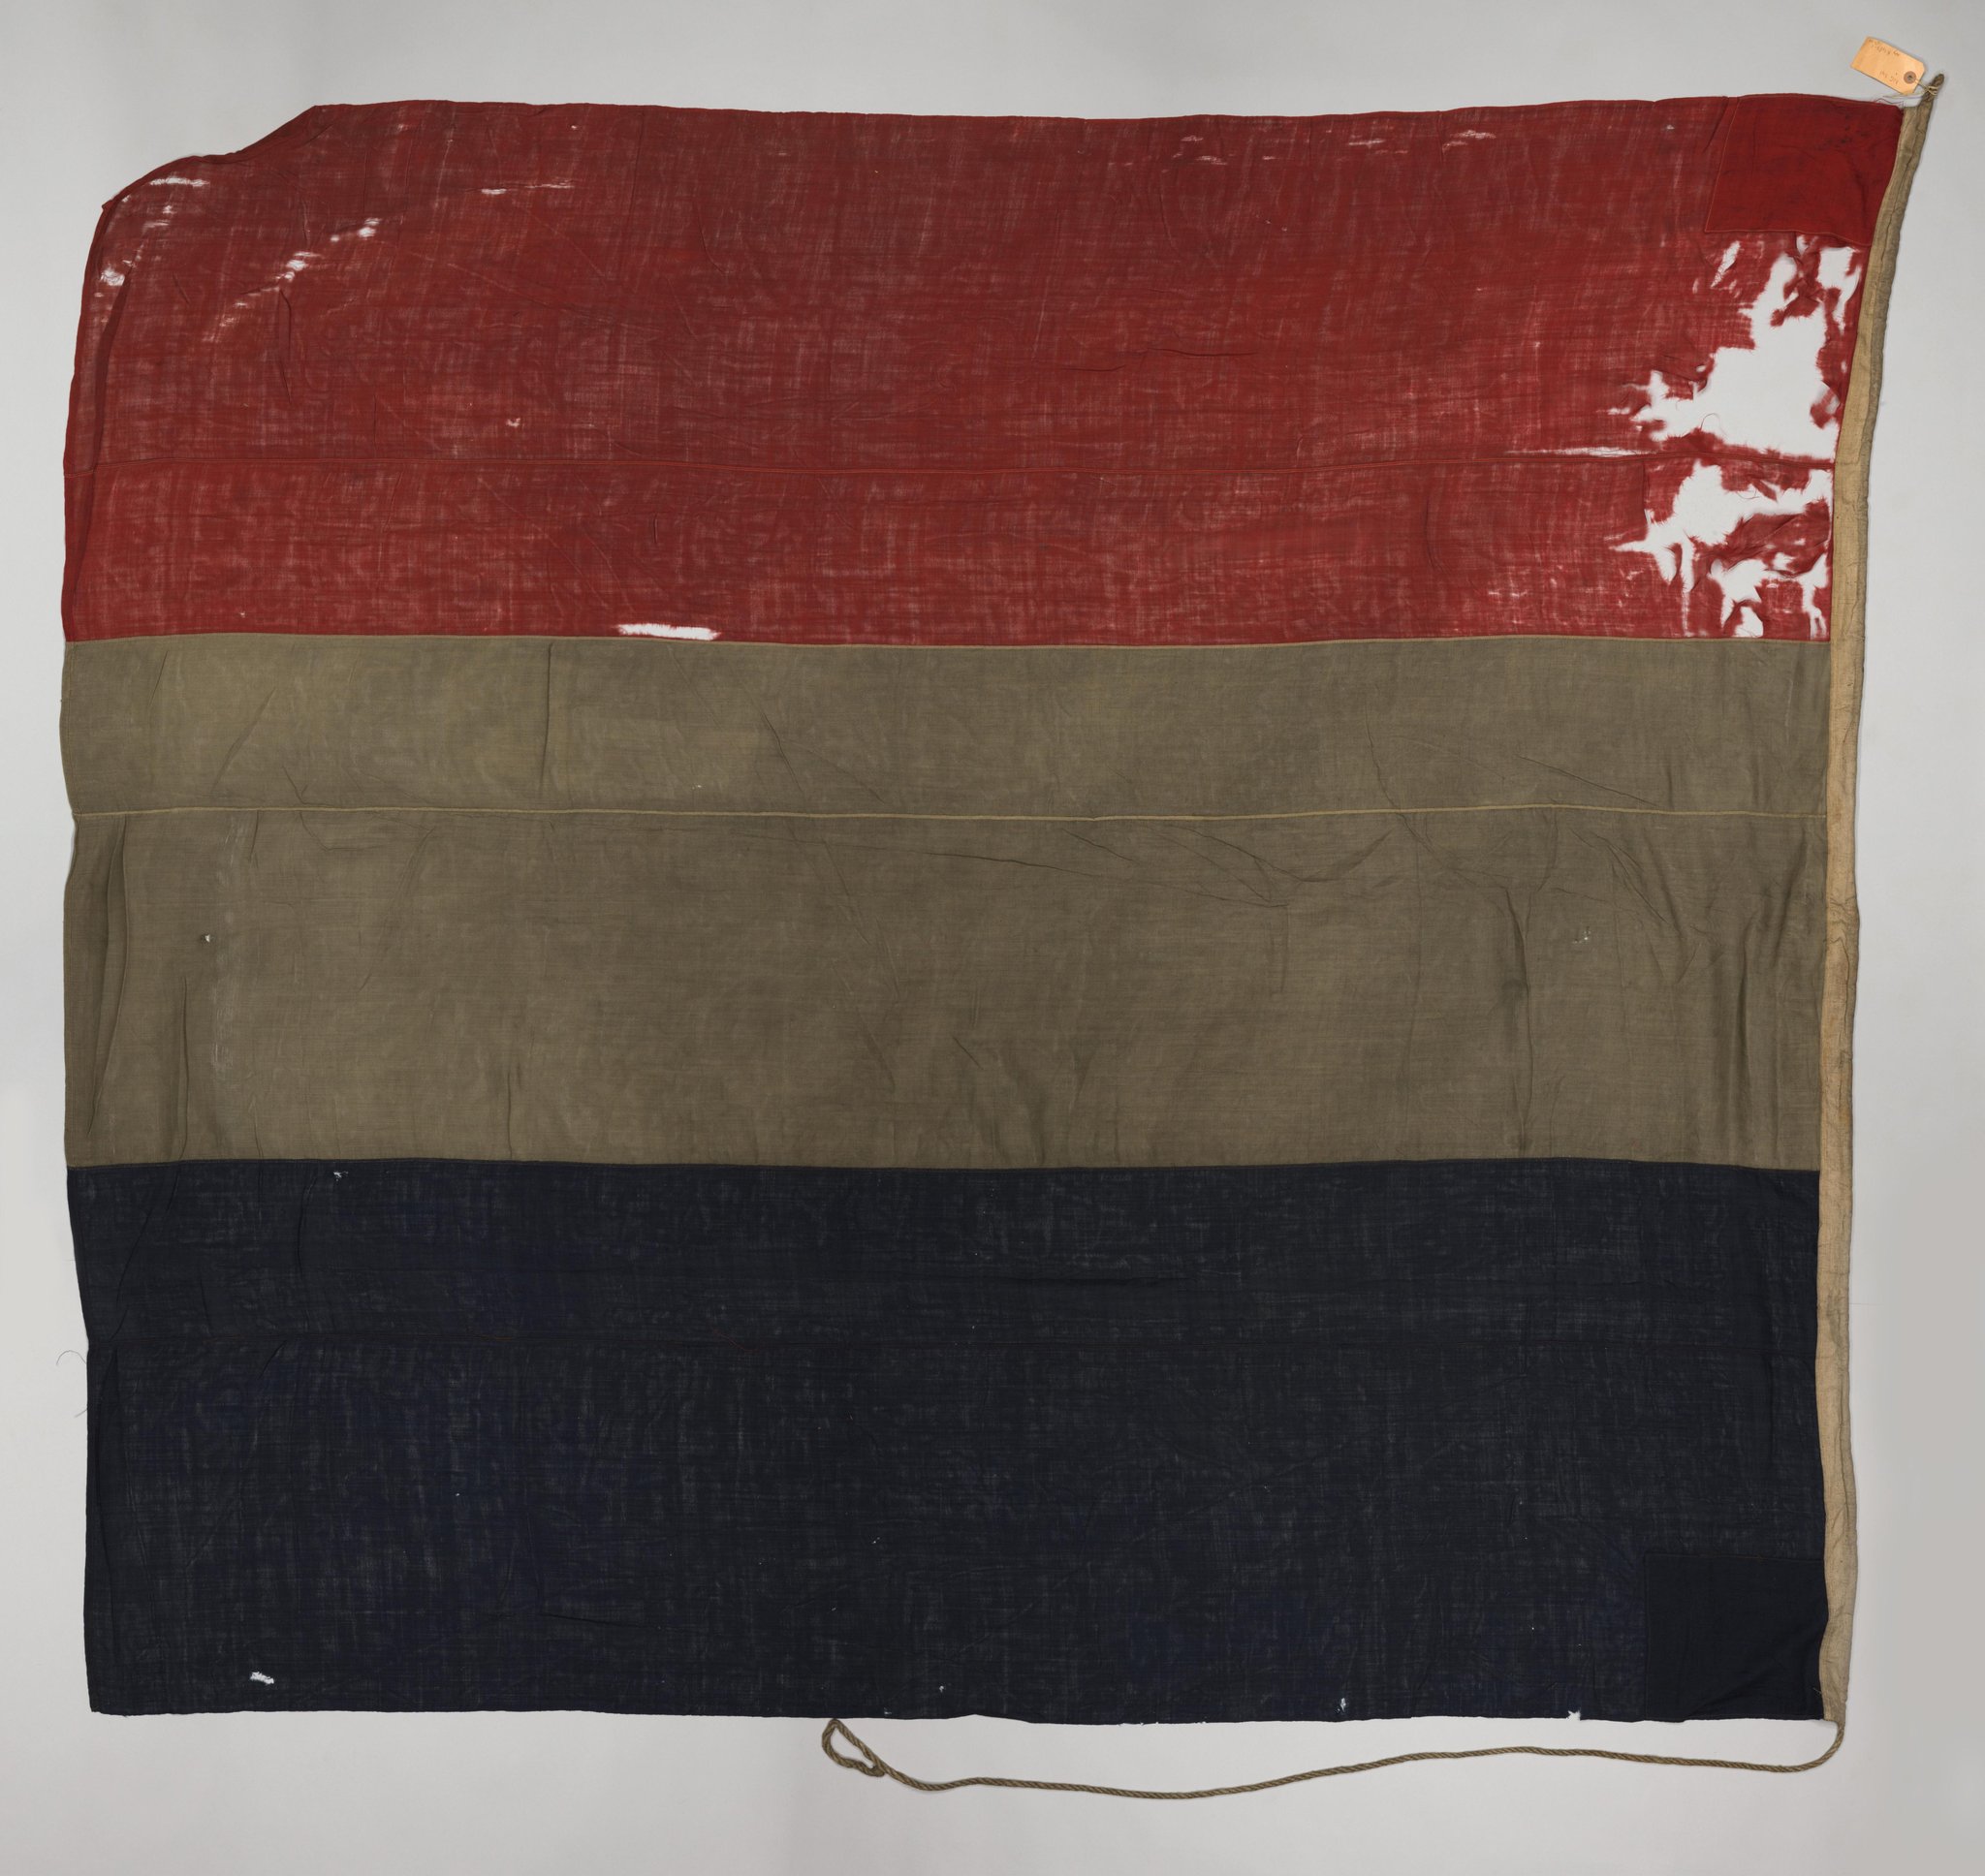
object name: ship flag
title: Scheepsvlag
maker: Anonymous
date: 1800-1890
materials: wool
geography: netherlands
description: Drie banen rood-wit-blauw. Opschrift: NED VL 4«KD.